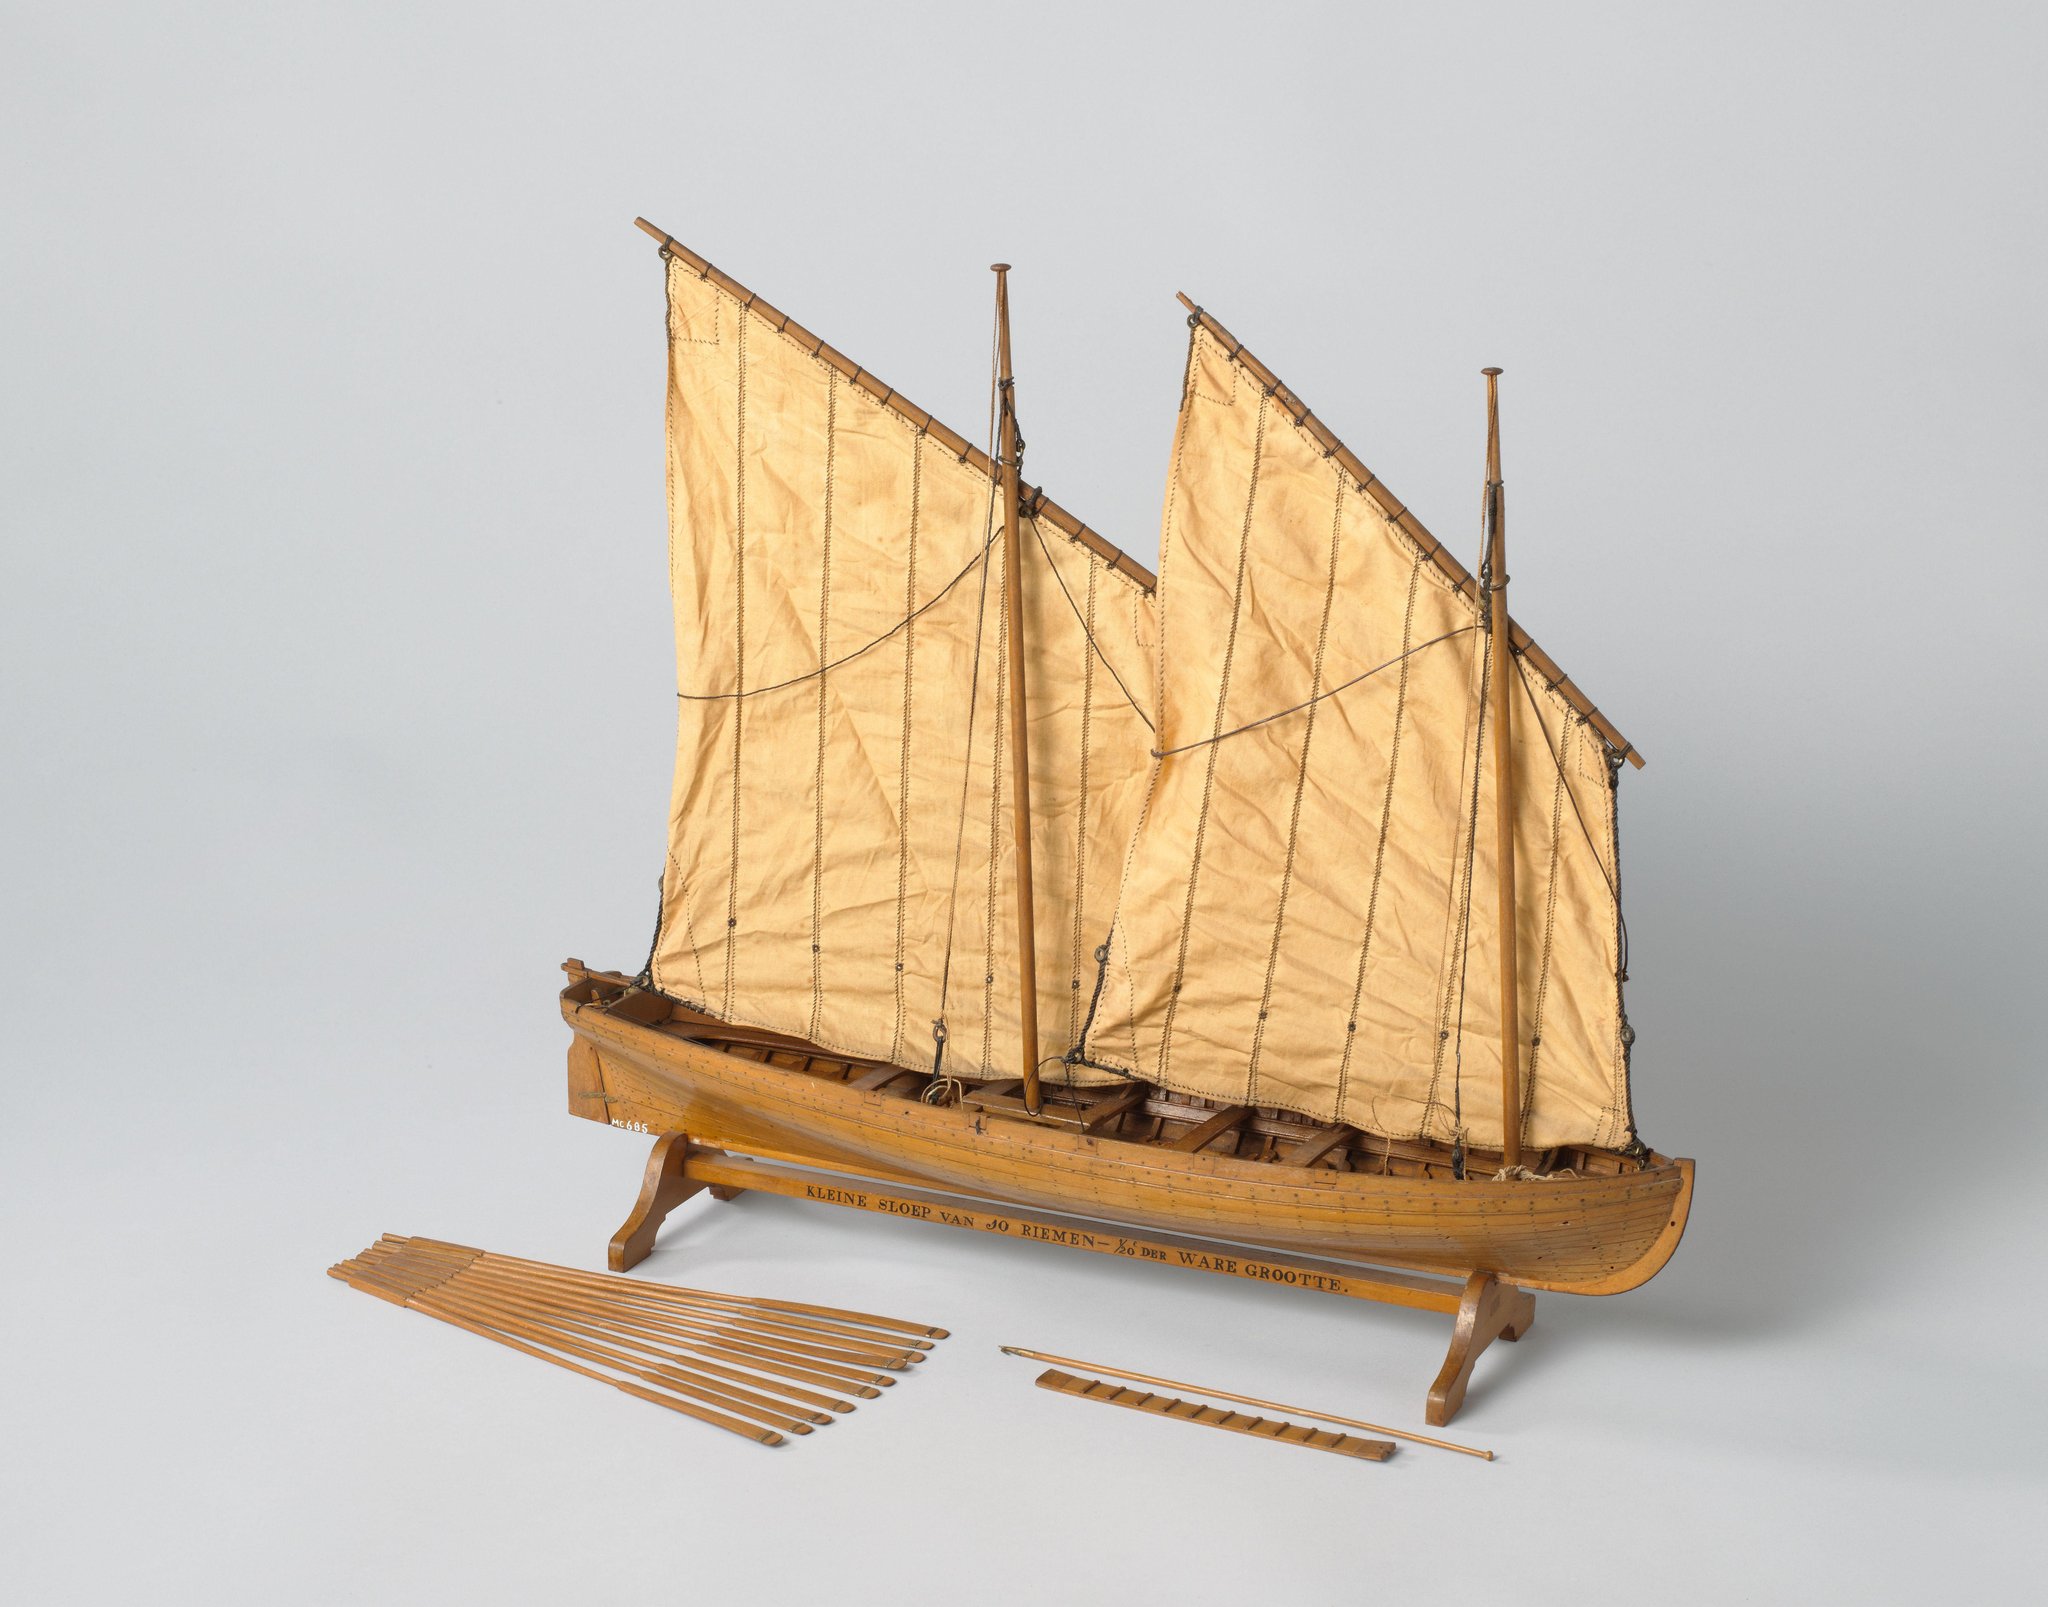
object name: instruction model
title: Model of a Launch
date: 1835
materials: brass, fiber, textile, wood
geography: flushing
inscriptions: inscription, on the stand: ‘KLEINE SLOEP VAN 10 RIEMEN - 1/20e DER WARE GROOTTE’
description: Getuigd spantmodel op een standaard. Gladboordige dubbelriems sloep, rondspant met platte spiegel; een voorplecht, vijf doften en spoorstokken, en een open kajuit met zijdoften. Driedelige spanten. Eenvoudig roer met een houten helmstok. Het tuig bestaat uit een grootzeil en fok, beide loggerzeilen. Het model heeft tien roeiriemen, een loopgang en twee boothaken. Schaal 1:20 (schaal op model).